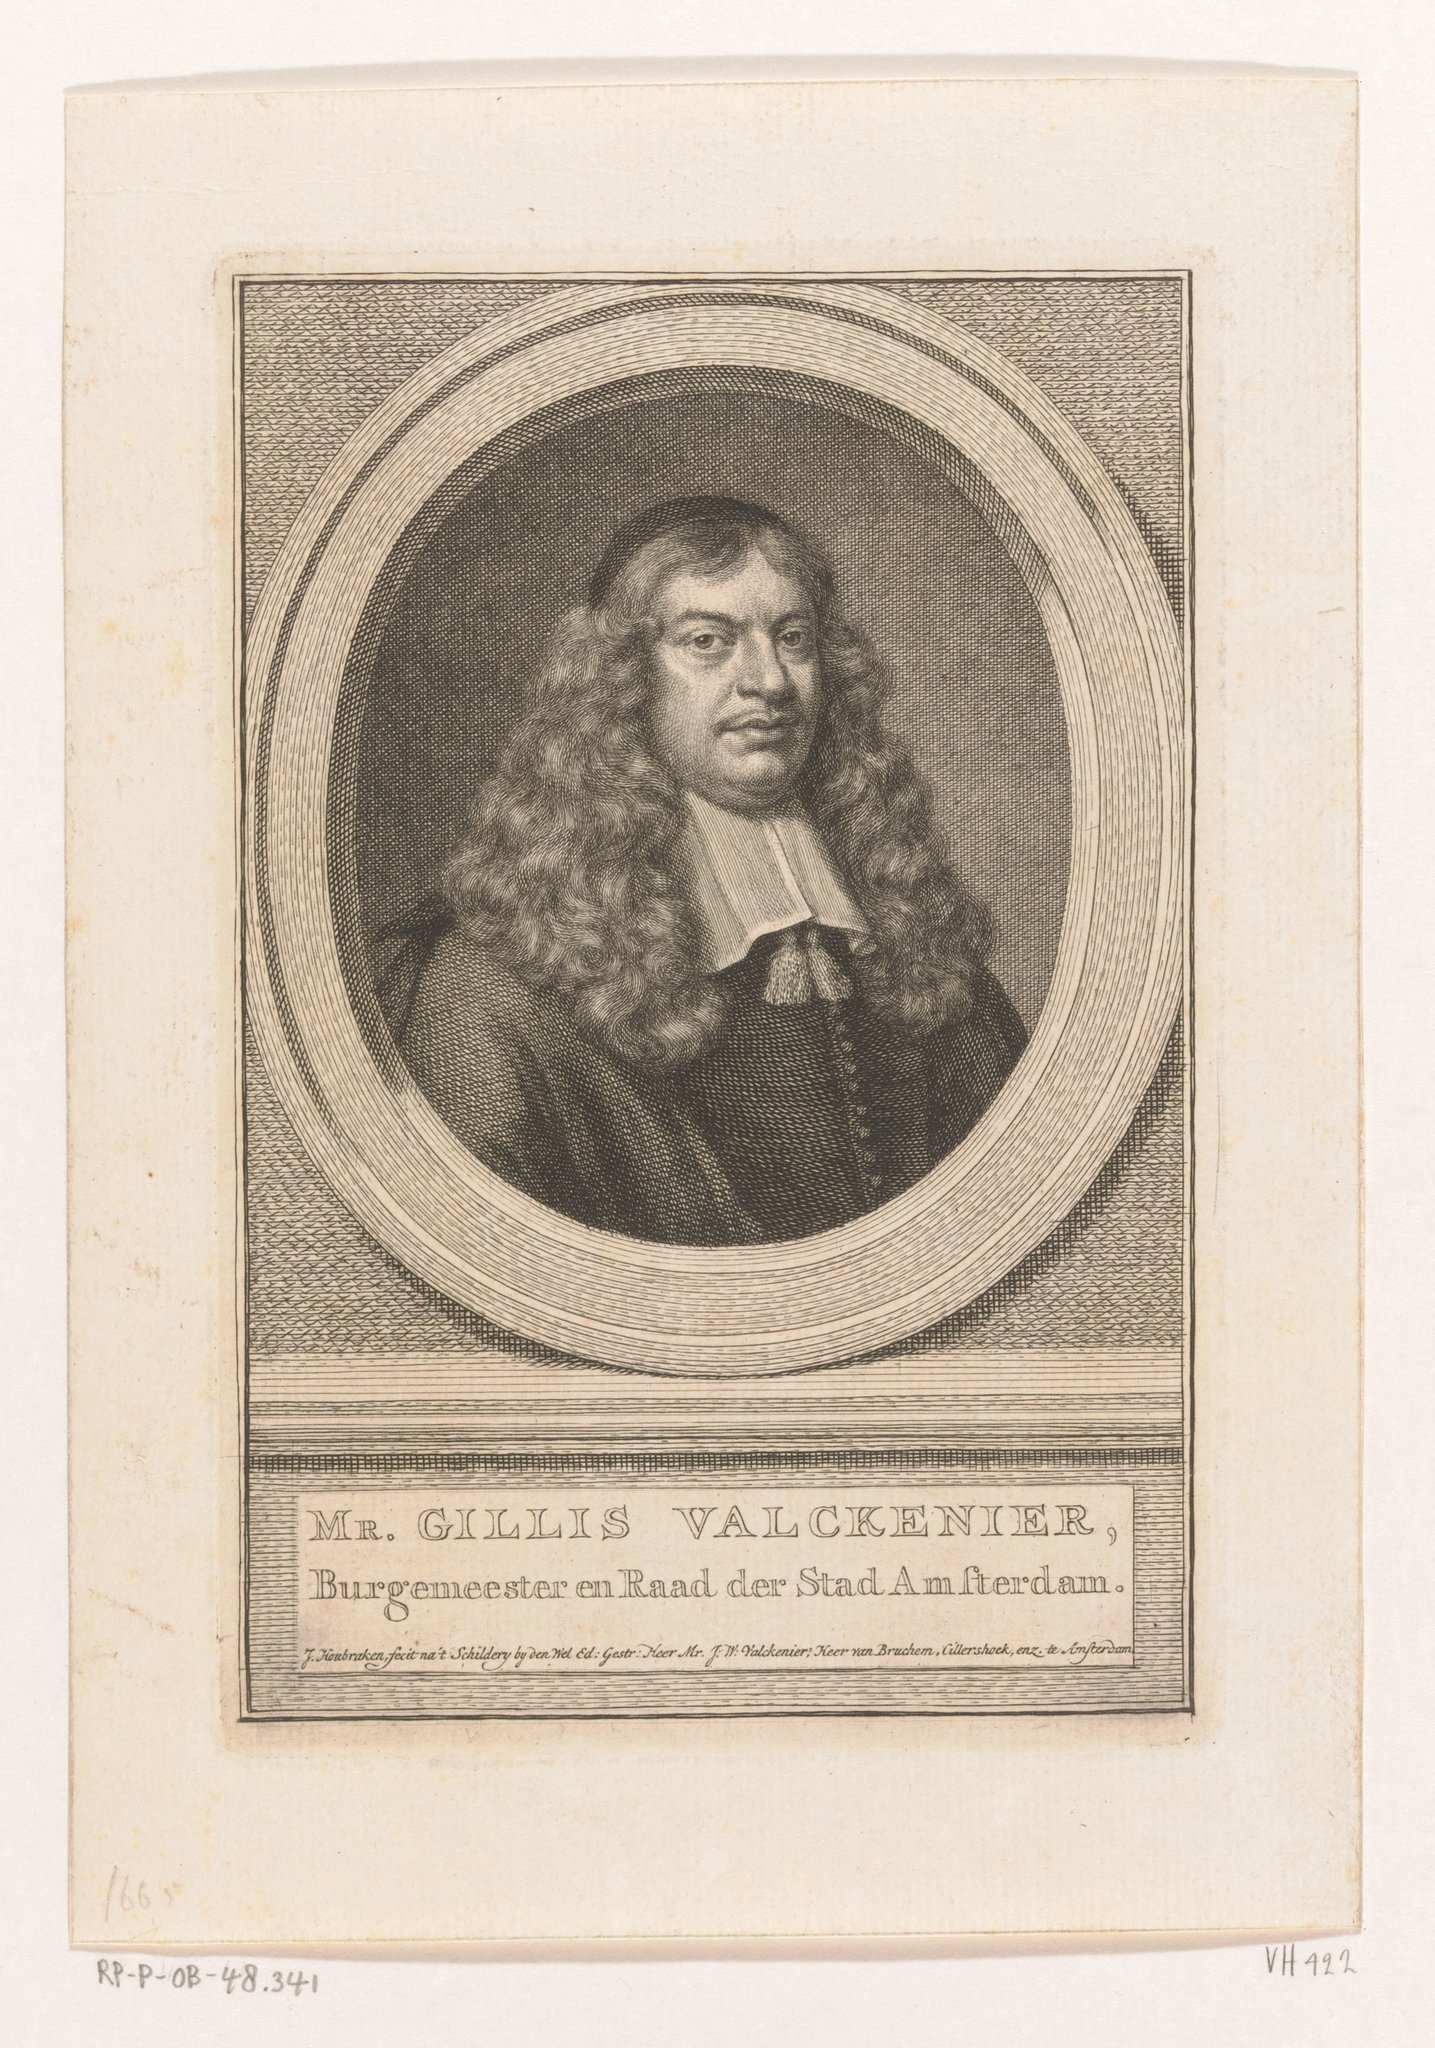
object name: print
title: Portret van Gillis Valckenier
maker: jacob houbraken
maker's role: draughtsman, print maker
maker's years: 1698-1780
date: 1749-1780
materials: paper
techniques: engraving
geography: amsterdam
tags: historical persons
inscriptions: collector's mark: Lugt 2228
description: Deze prent is oorspronkelijk bedoeld als aanvulling op Jan Wagenaars ‘Vaderlandsche historie’* en was zo vanaf 1796 verkrijgbaar bij Johannes Allart te Amsterdam. Voor de advertentie waarin Allart de 60 portretten en 7 platen, allen gegraveerd door Houbraken, ter aanvulling op Wagenaars ‘Vaderlandsche historie’ aanbiedt, zie RP-P-OB-77.766. *Van dit werk zijn in de achttiende eeuw meerdere uitgaves verschenen, zoals: Wagenaar, Jan. Vaderlandsche historie, vervattende de geschiedenissen der Vereenigde Nederlanden (…). 21 delen. Amsterdam: Isaak Tirion, 1749-1759. Wagenaar, Jan. Vaderlandsche historie, vervattende de geschiedenissen der nu Vereenigde Nederlanden (…). 21 delen. Amsterdam: weduwe Isaak Tirion, 1770. Wagenaar, Jan. Vaderlandsche historie, vervattende de geschiedenissen der nu Vereenigde Nederlanden (…). 21 delen. Amsterdam, Leiden, Dordrecht en Harlingen: P. Schouten e.a., 1782. Wagenaar, Jan. Vaderlandsche historie, vervattende de geschiedenissen der nu Vereenigde Nederlanden (…). 21 delen. Amsterdam: Johannes Allart, 1790-1796.